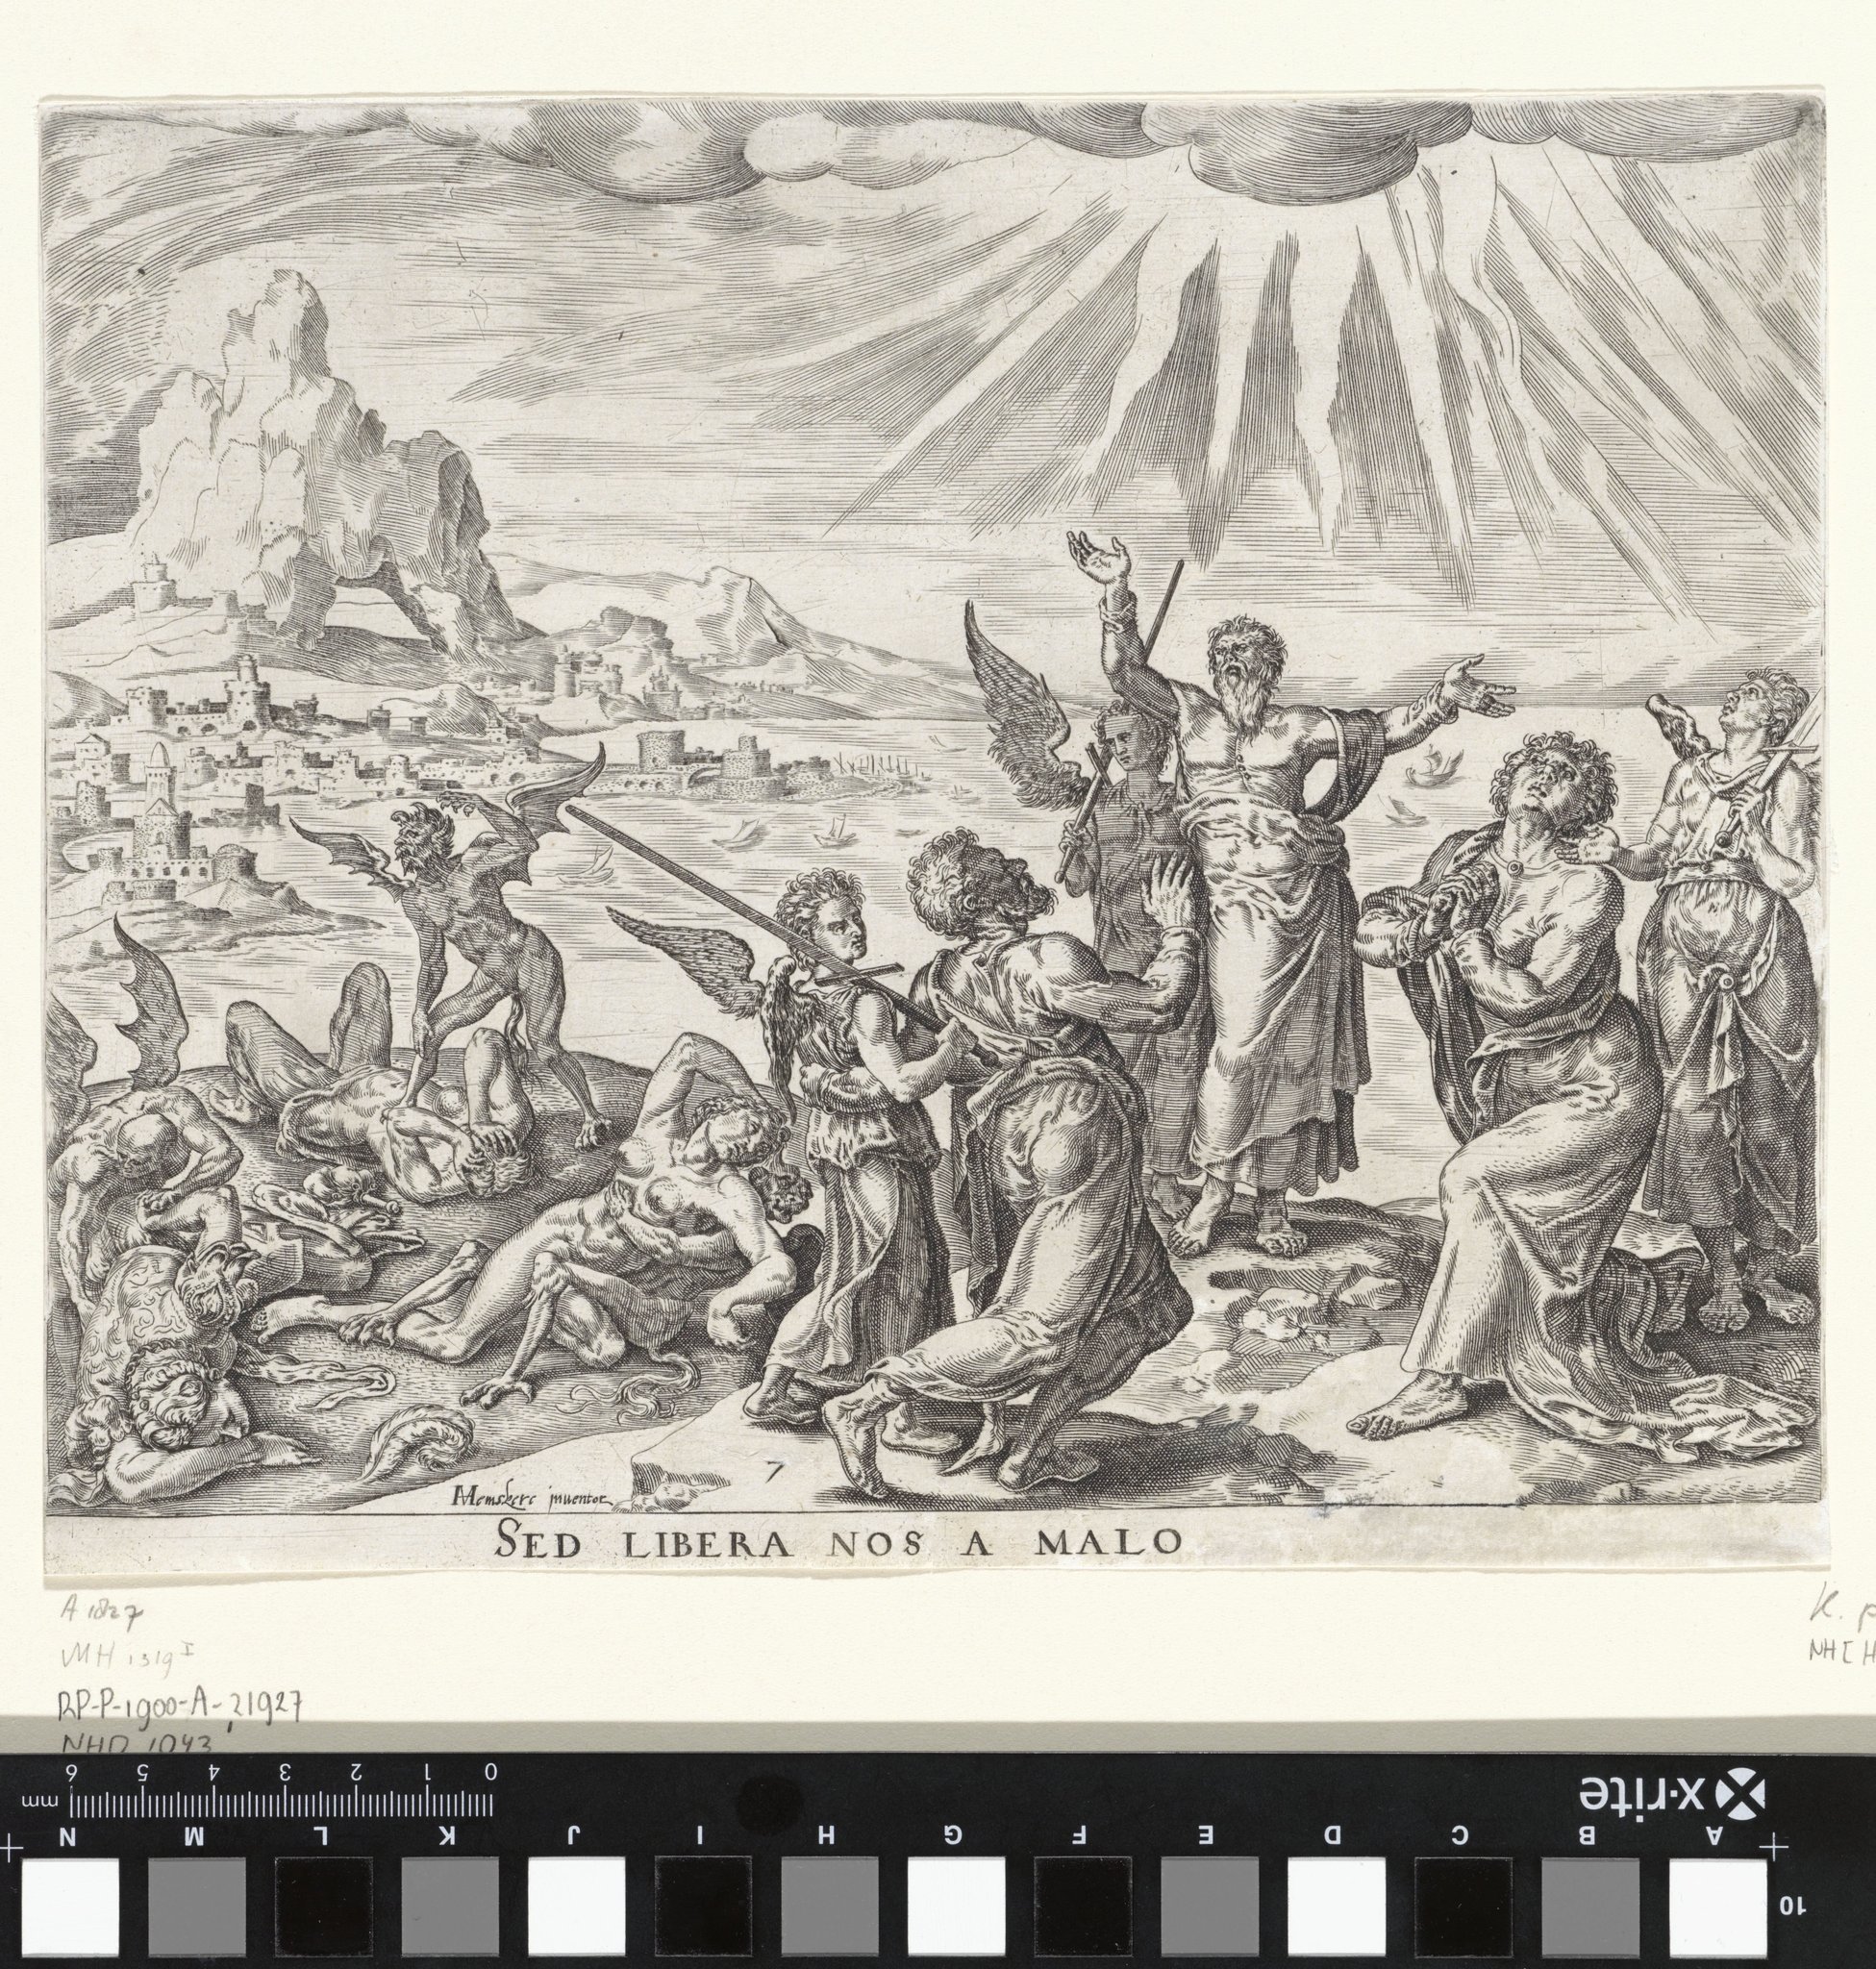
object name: print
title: Onze Vader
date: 1569-1573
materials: paper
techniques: engraving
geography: antwerp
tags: 'but deliver us from evil' ~ the lord's prayer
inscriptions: collector's mark: Lugt 2228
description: Mensen bidden richting de hemel. Ze worden door engelen bevrijdt van het kwaad. Stralen schijnen vanuit de hemel op hen. Het Latijnse onderschrift is een deel uit het gebed het Onze Vader.